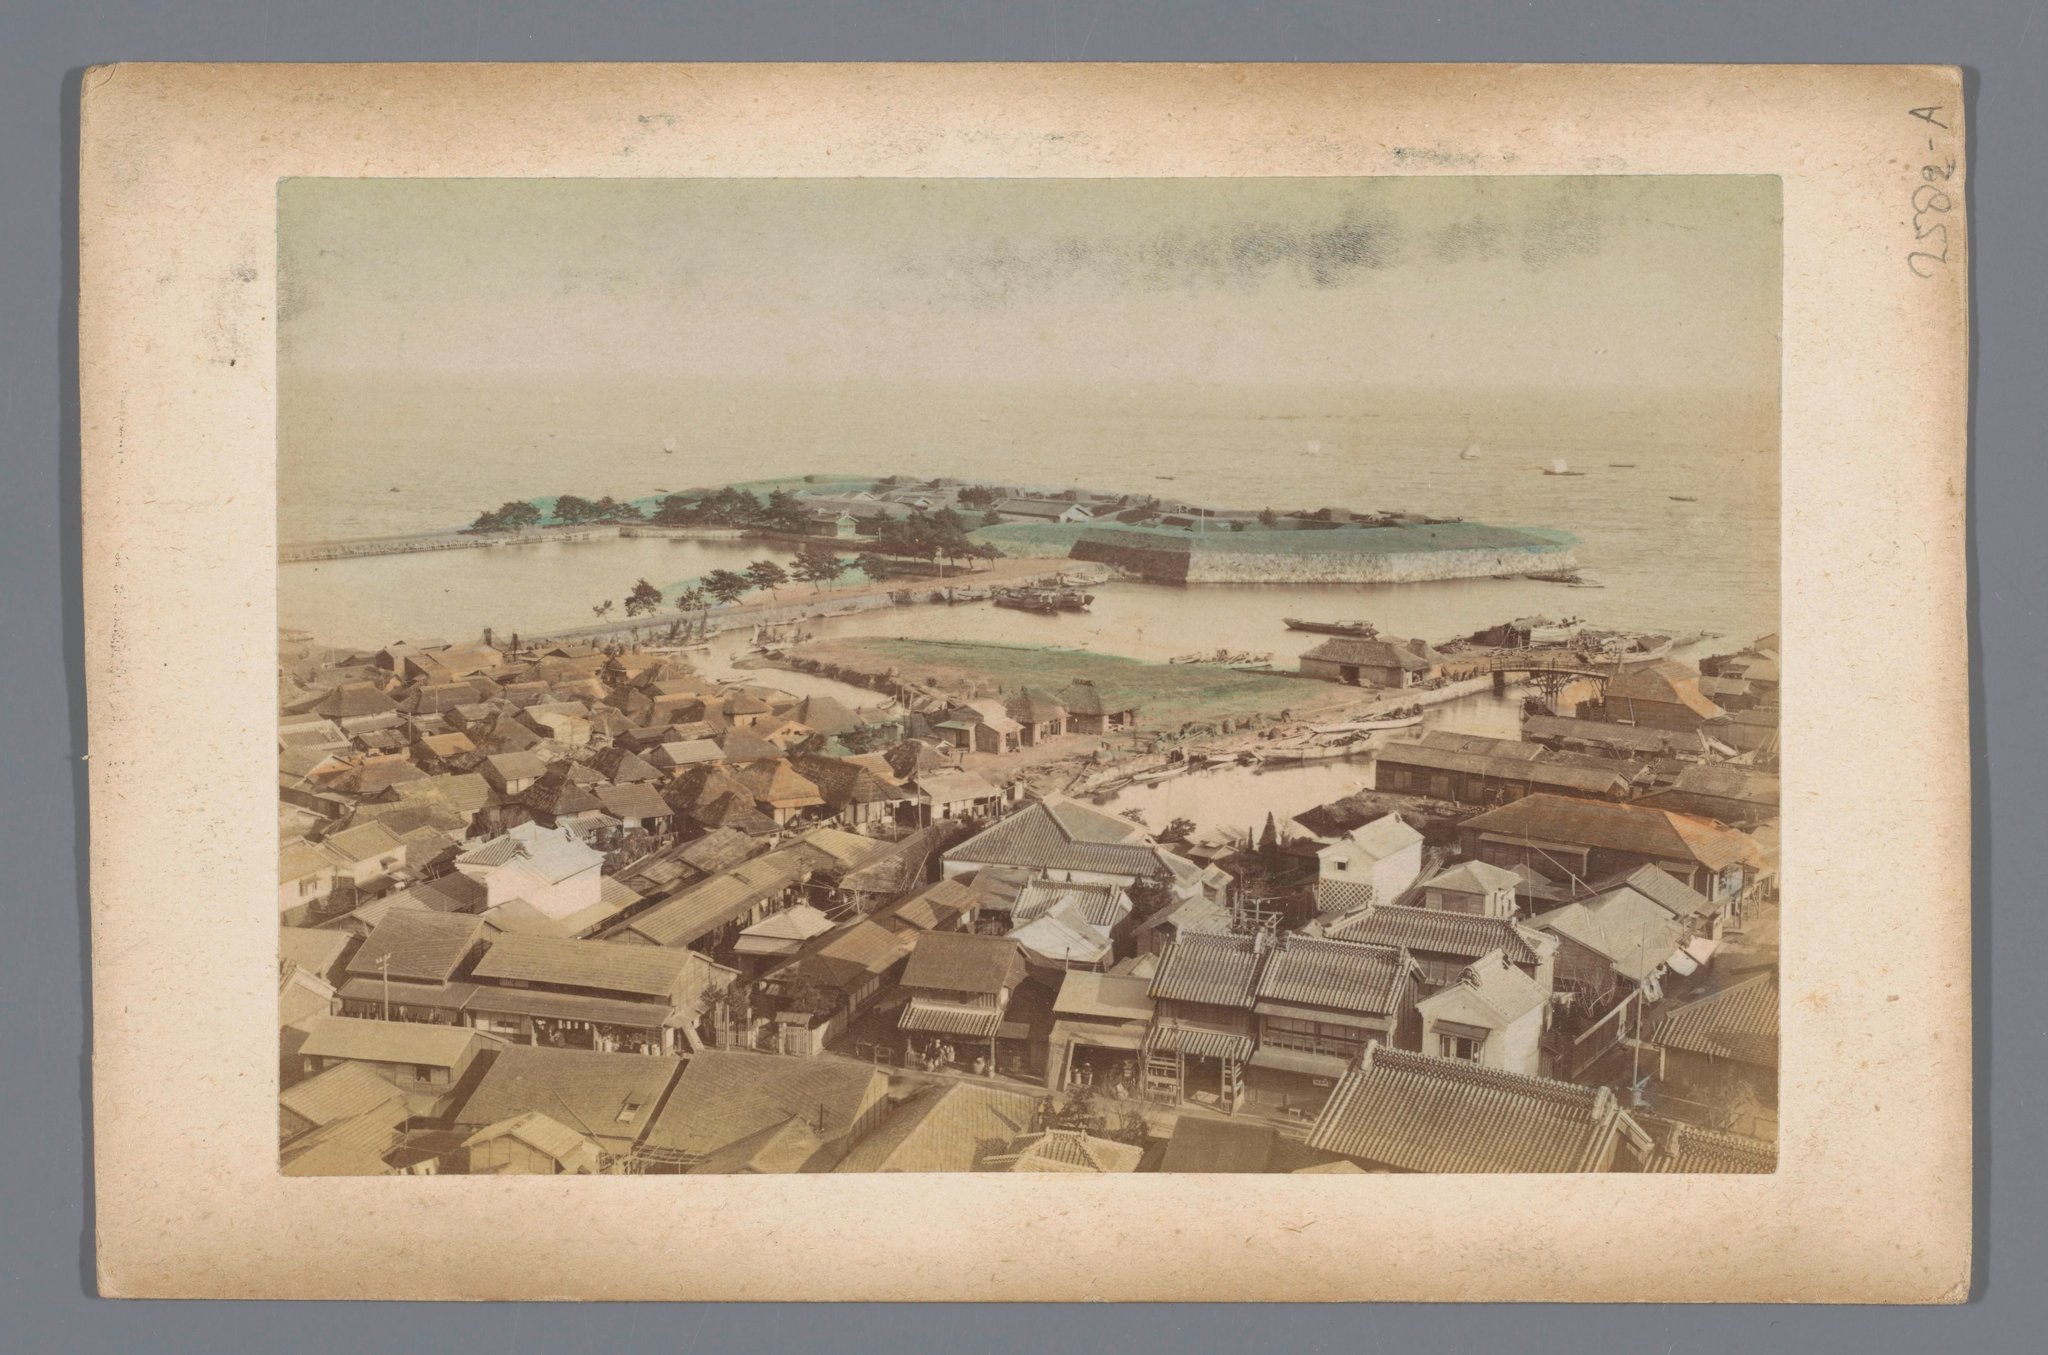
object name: photograph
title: Stadsgezicht aan zee in Japan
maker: Anonymous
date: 1860-1900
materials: cardboard, paper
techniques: albumen print, hand coloring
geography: japan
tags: city-view in general; 'veduta', japan